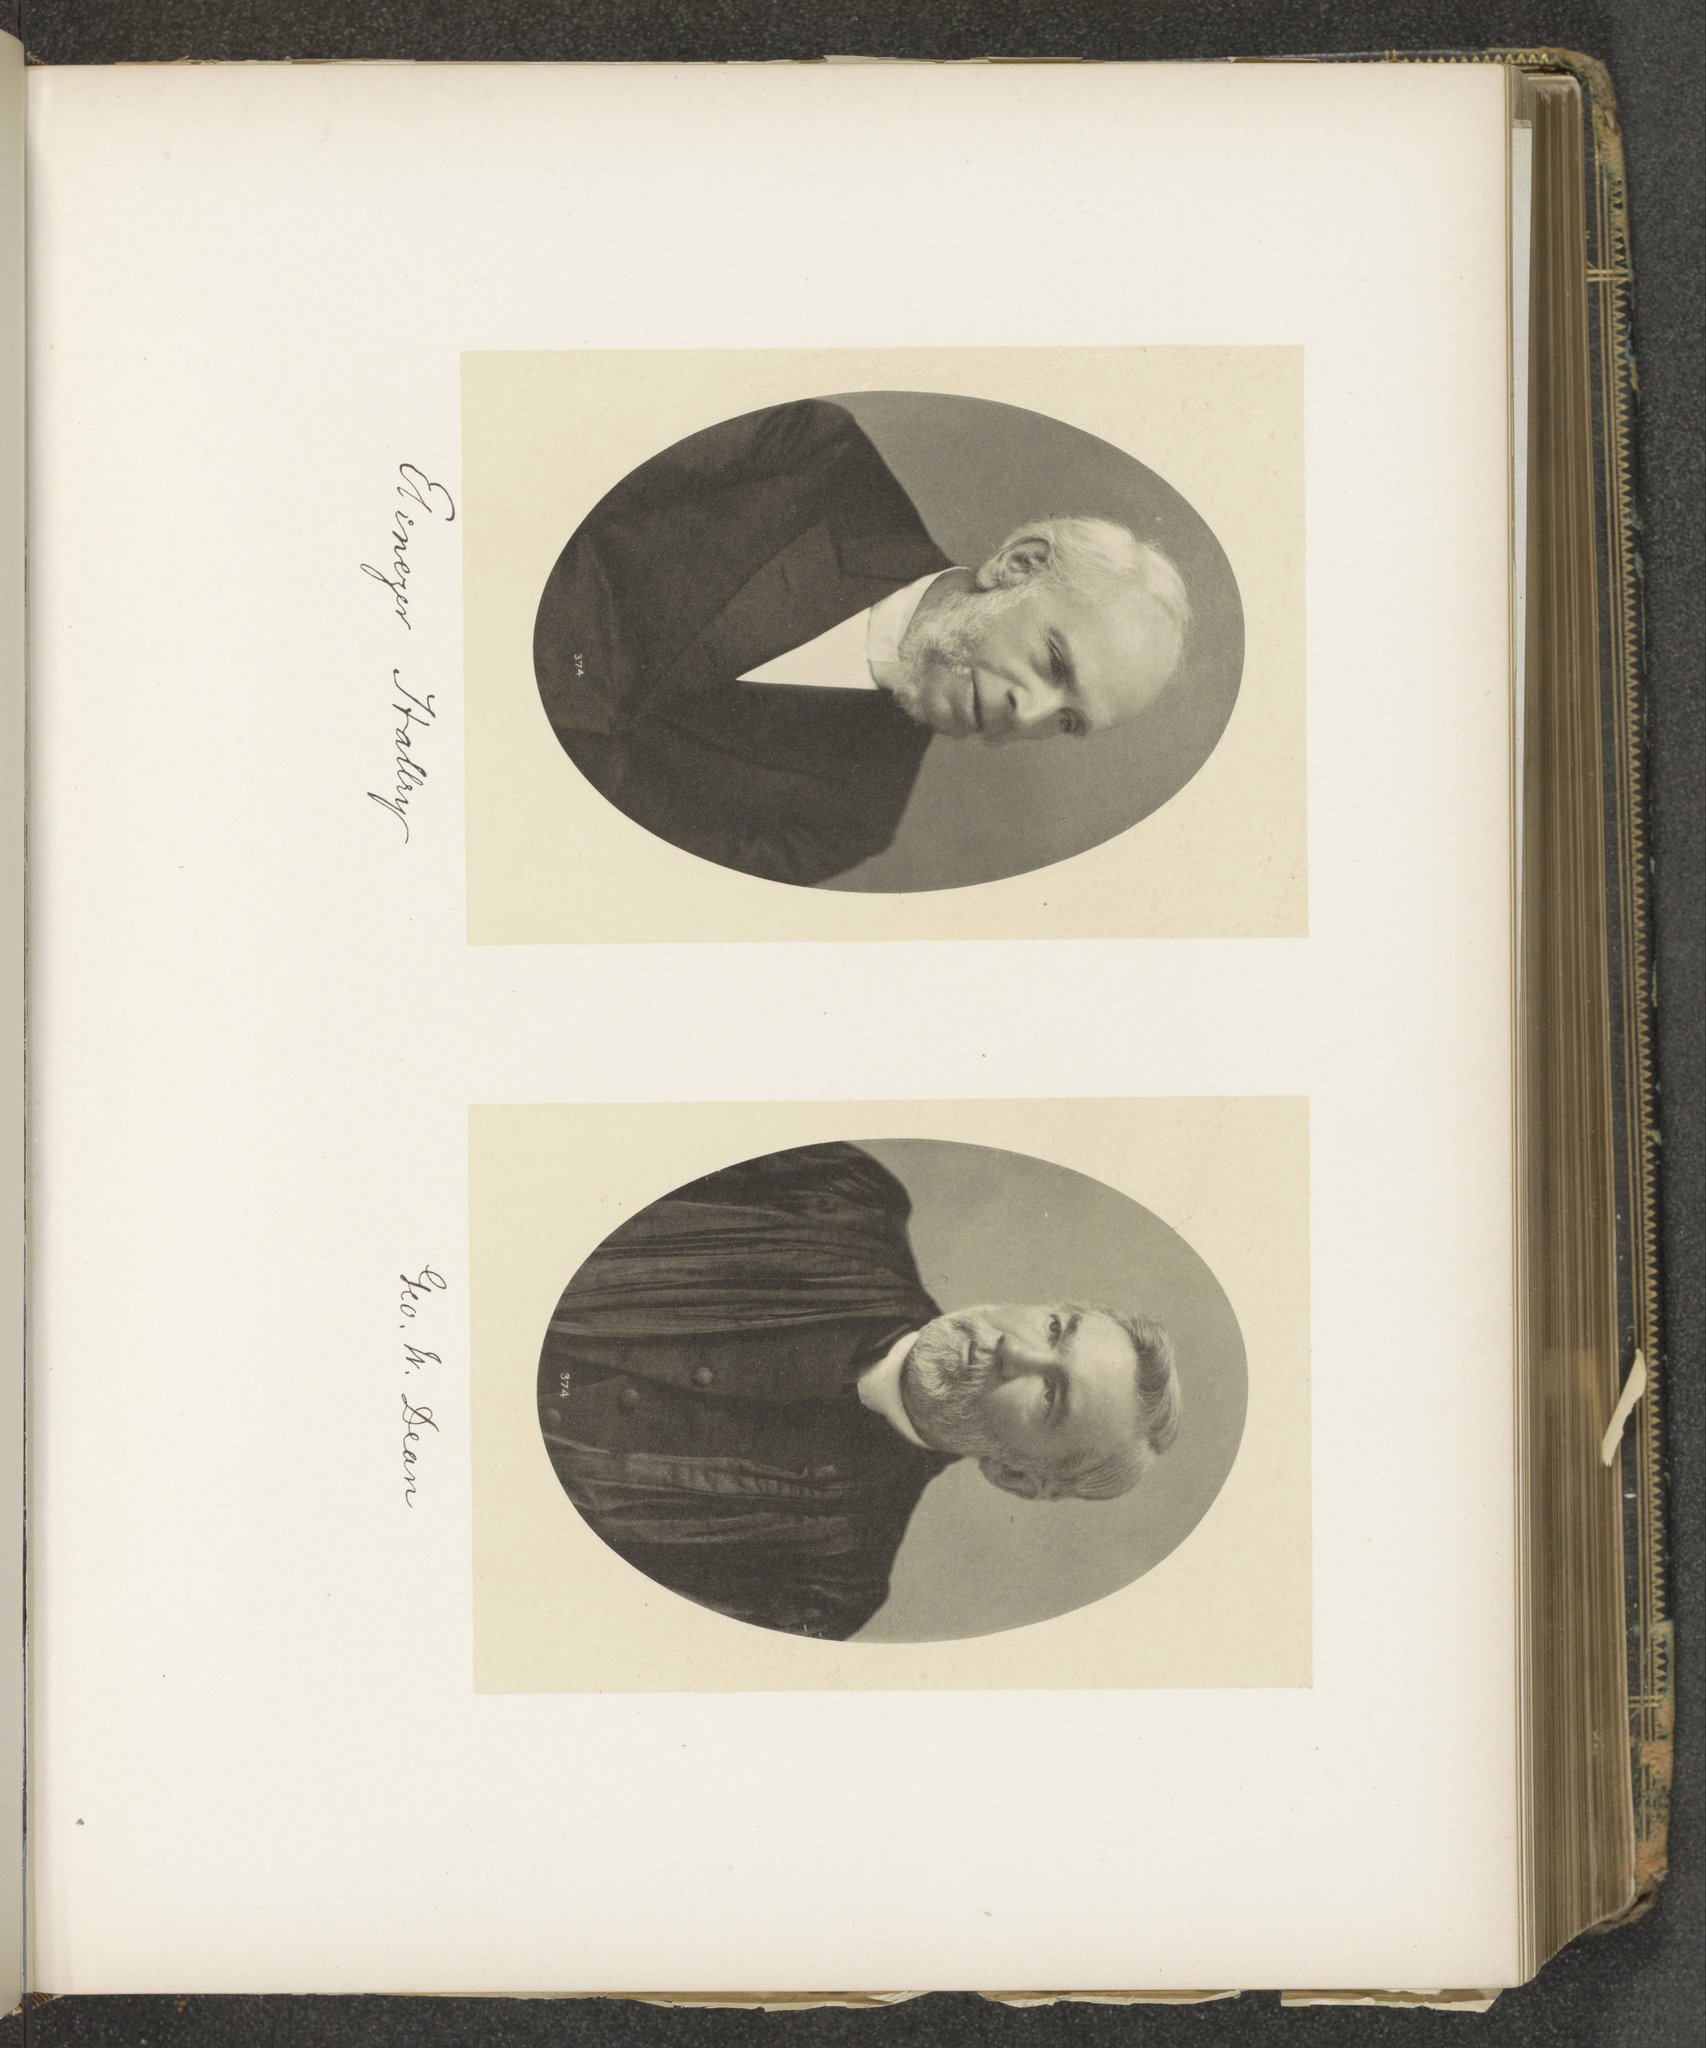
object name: photomechanical print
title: Portretten van twee kapelaans van de senaat van de staat New York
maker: Anonymous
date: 1872-1882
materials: paper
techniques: photograph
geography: united states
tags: historical persons (portraits and scenes from the life) (+ head (and shoulders) (portrait))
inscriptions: annotation, number: ‘374’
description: Links Ebenezer Hally, rechts George W. Dean.